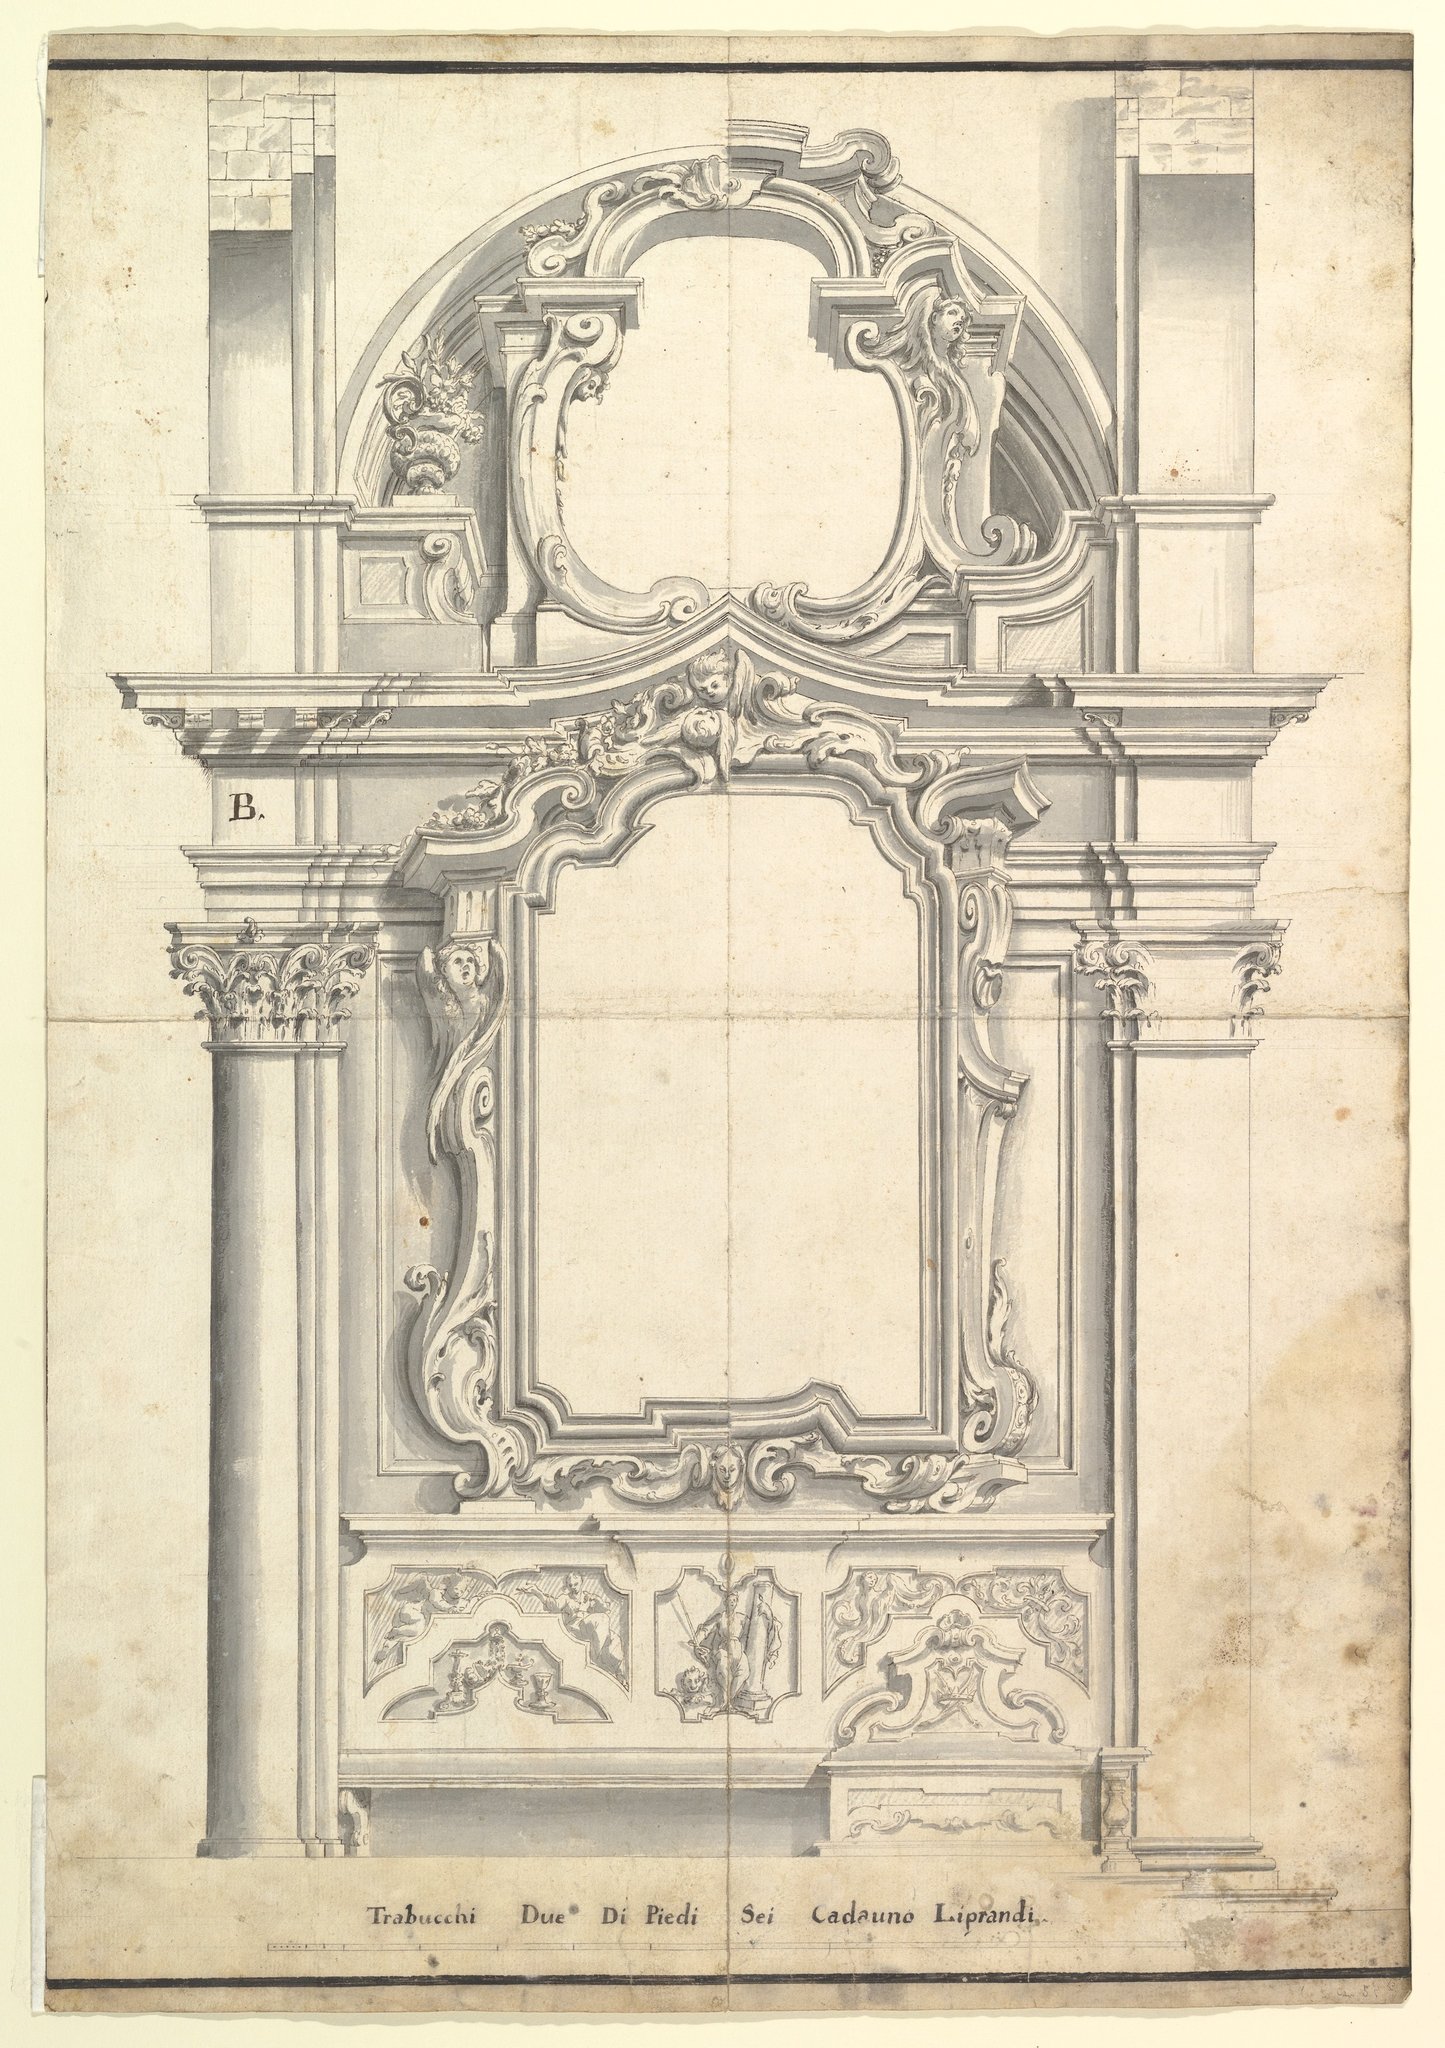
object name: drawing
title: Two Alternate Designs for a Wall with a Frame for a Painting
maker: anonymous, italian, piedmontese, 18th century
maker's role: artist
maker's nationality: italian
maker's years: 1700-1800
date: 1700-1780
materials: graphite, ink, drawing material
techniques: brush, pen, wash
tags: cartouches